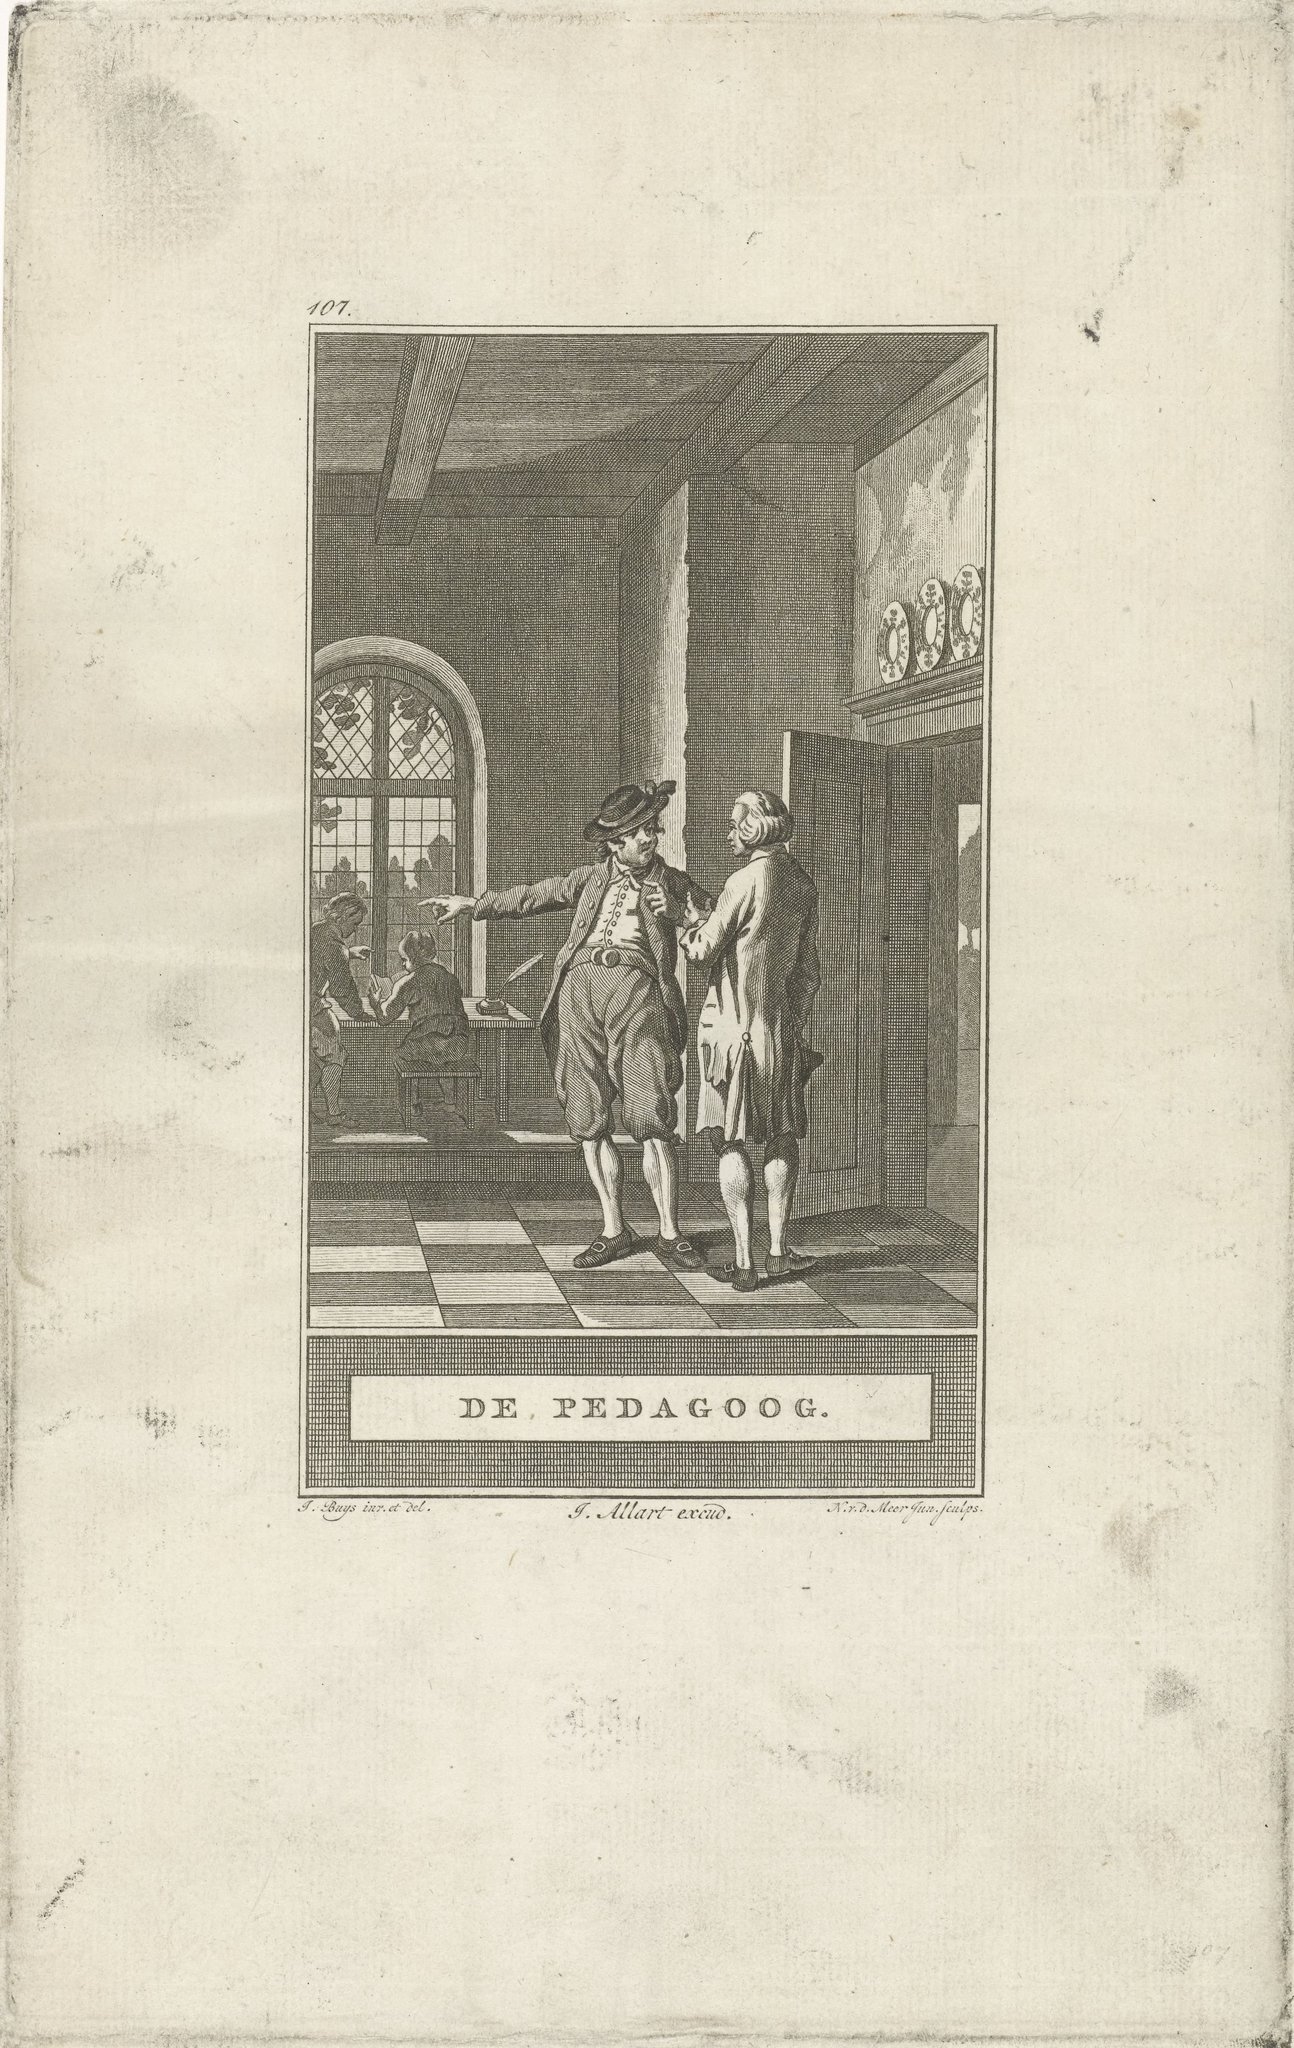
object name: book illustration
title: De pedagoog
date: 1778-1785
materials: paper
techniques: etching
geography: amsterdam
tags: farmers, teacher and pupil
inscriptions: collector's mark: Lugt 2228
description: Prent bij: Gellert, Christian Fürchtegott. Fabelen en vertelsels. 3 dln. Amsterdam: Pieter Meyer, 1772-1774. De prenten bij deze publicatie werden later uitgegeven. De exemplaren uitgegeven door de weduwe Jacobus Loveringh & Johannes Allart tussen 1777 en 1778, de exemplaren uitgegeven door alleen Johannes Allart tussen 1778 en 1785.